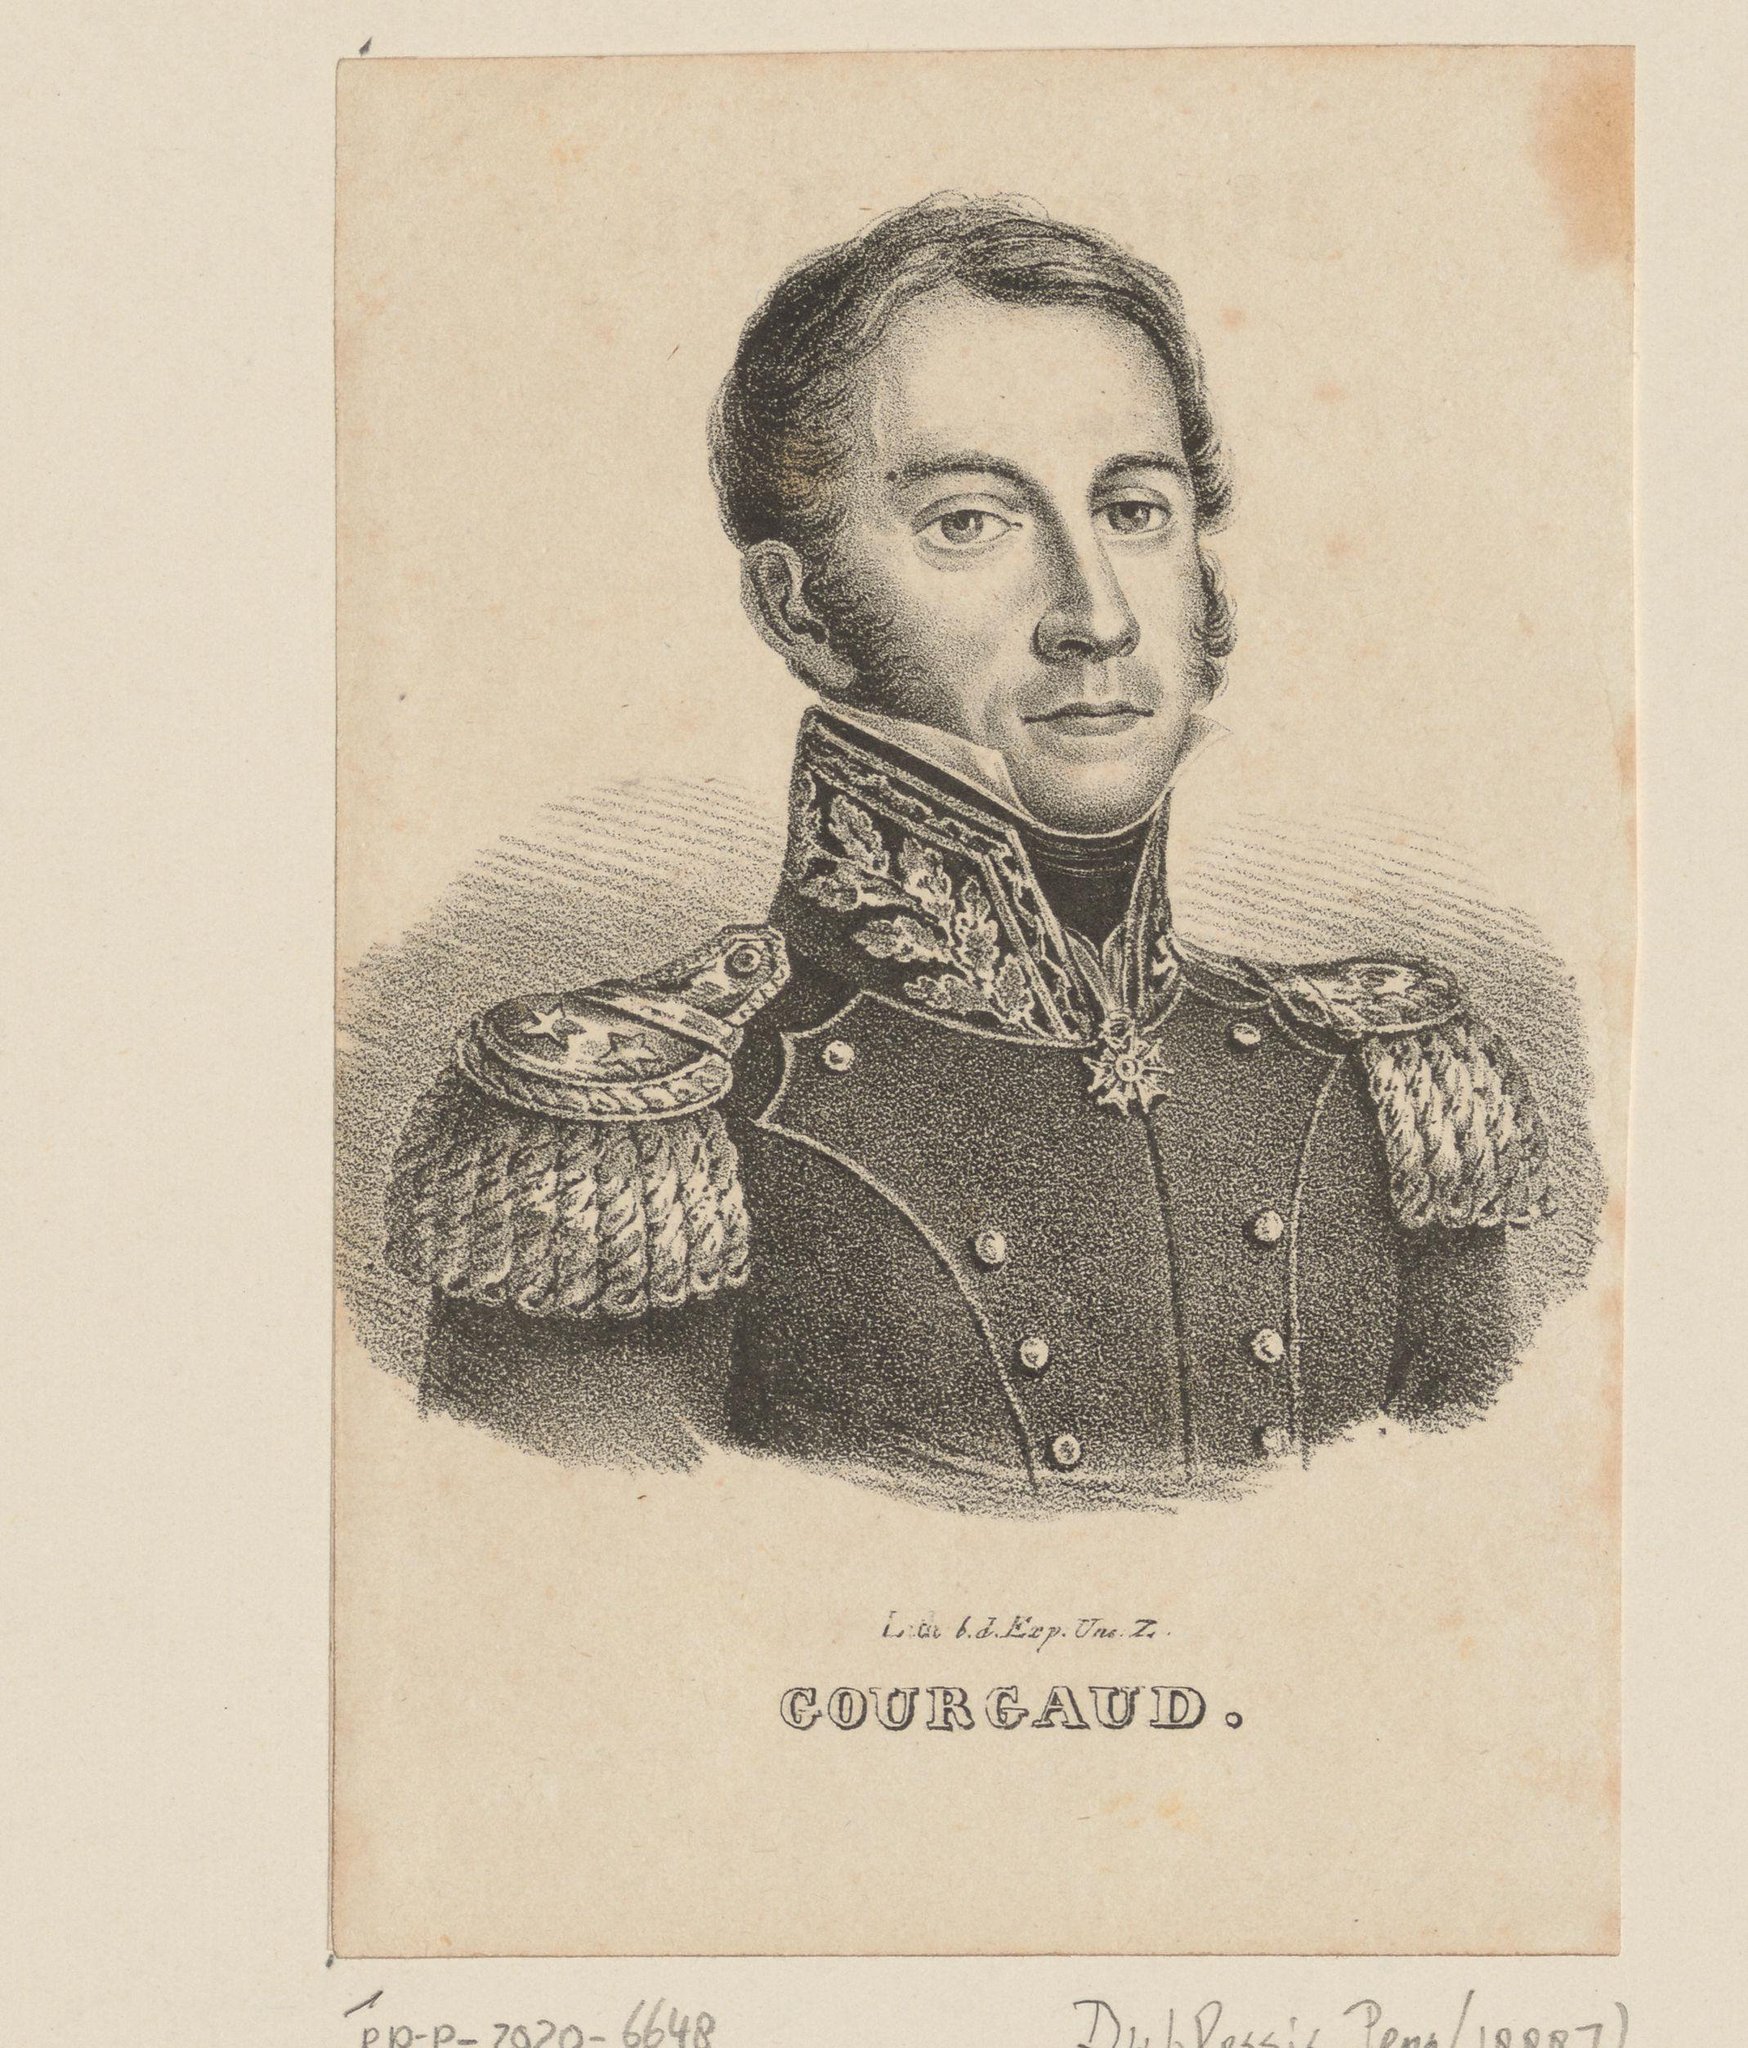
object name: print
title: Portret van Charles Gounod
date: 1852-1940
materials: paper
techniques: lithograph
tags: simon goulart, theologian, historical persons, portrait of a writer